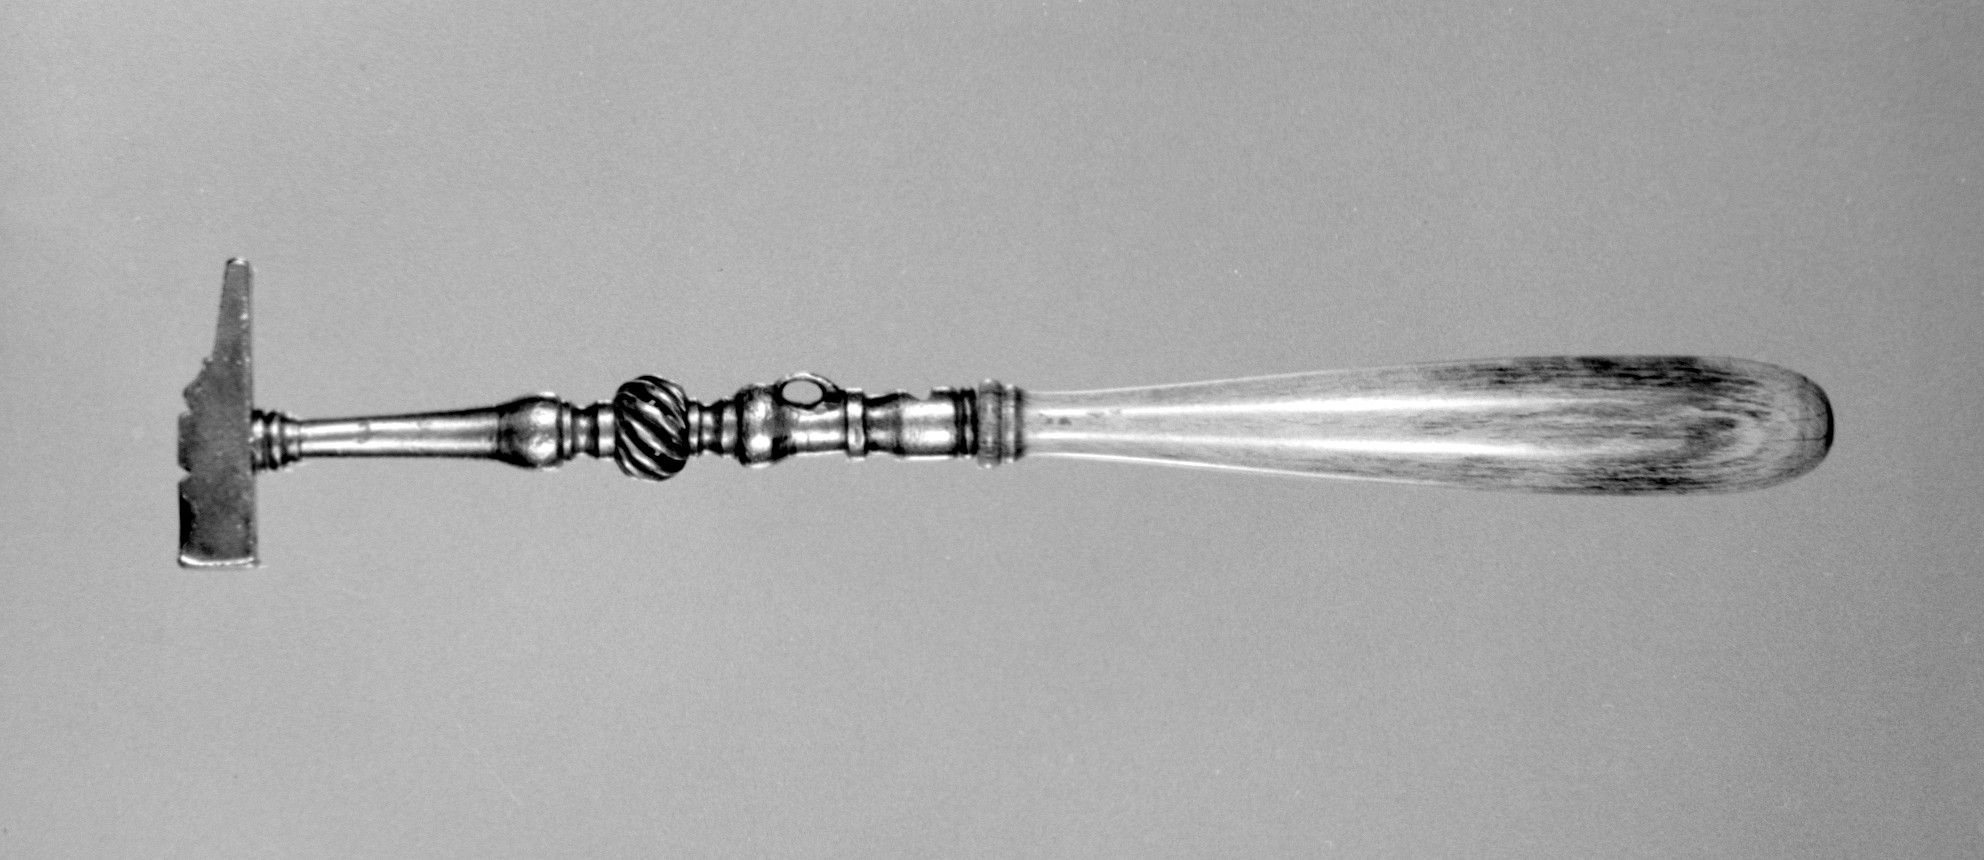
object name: hammer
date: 1701-1800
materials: steel, wood